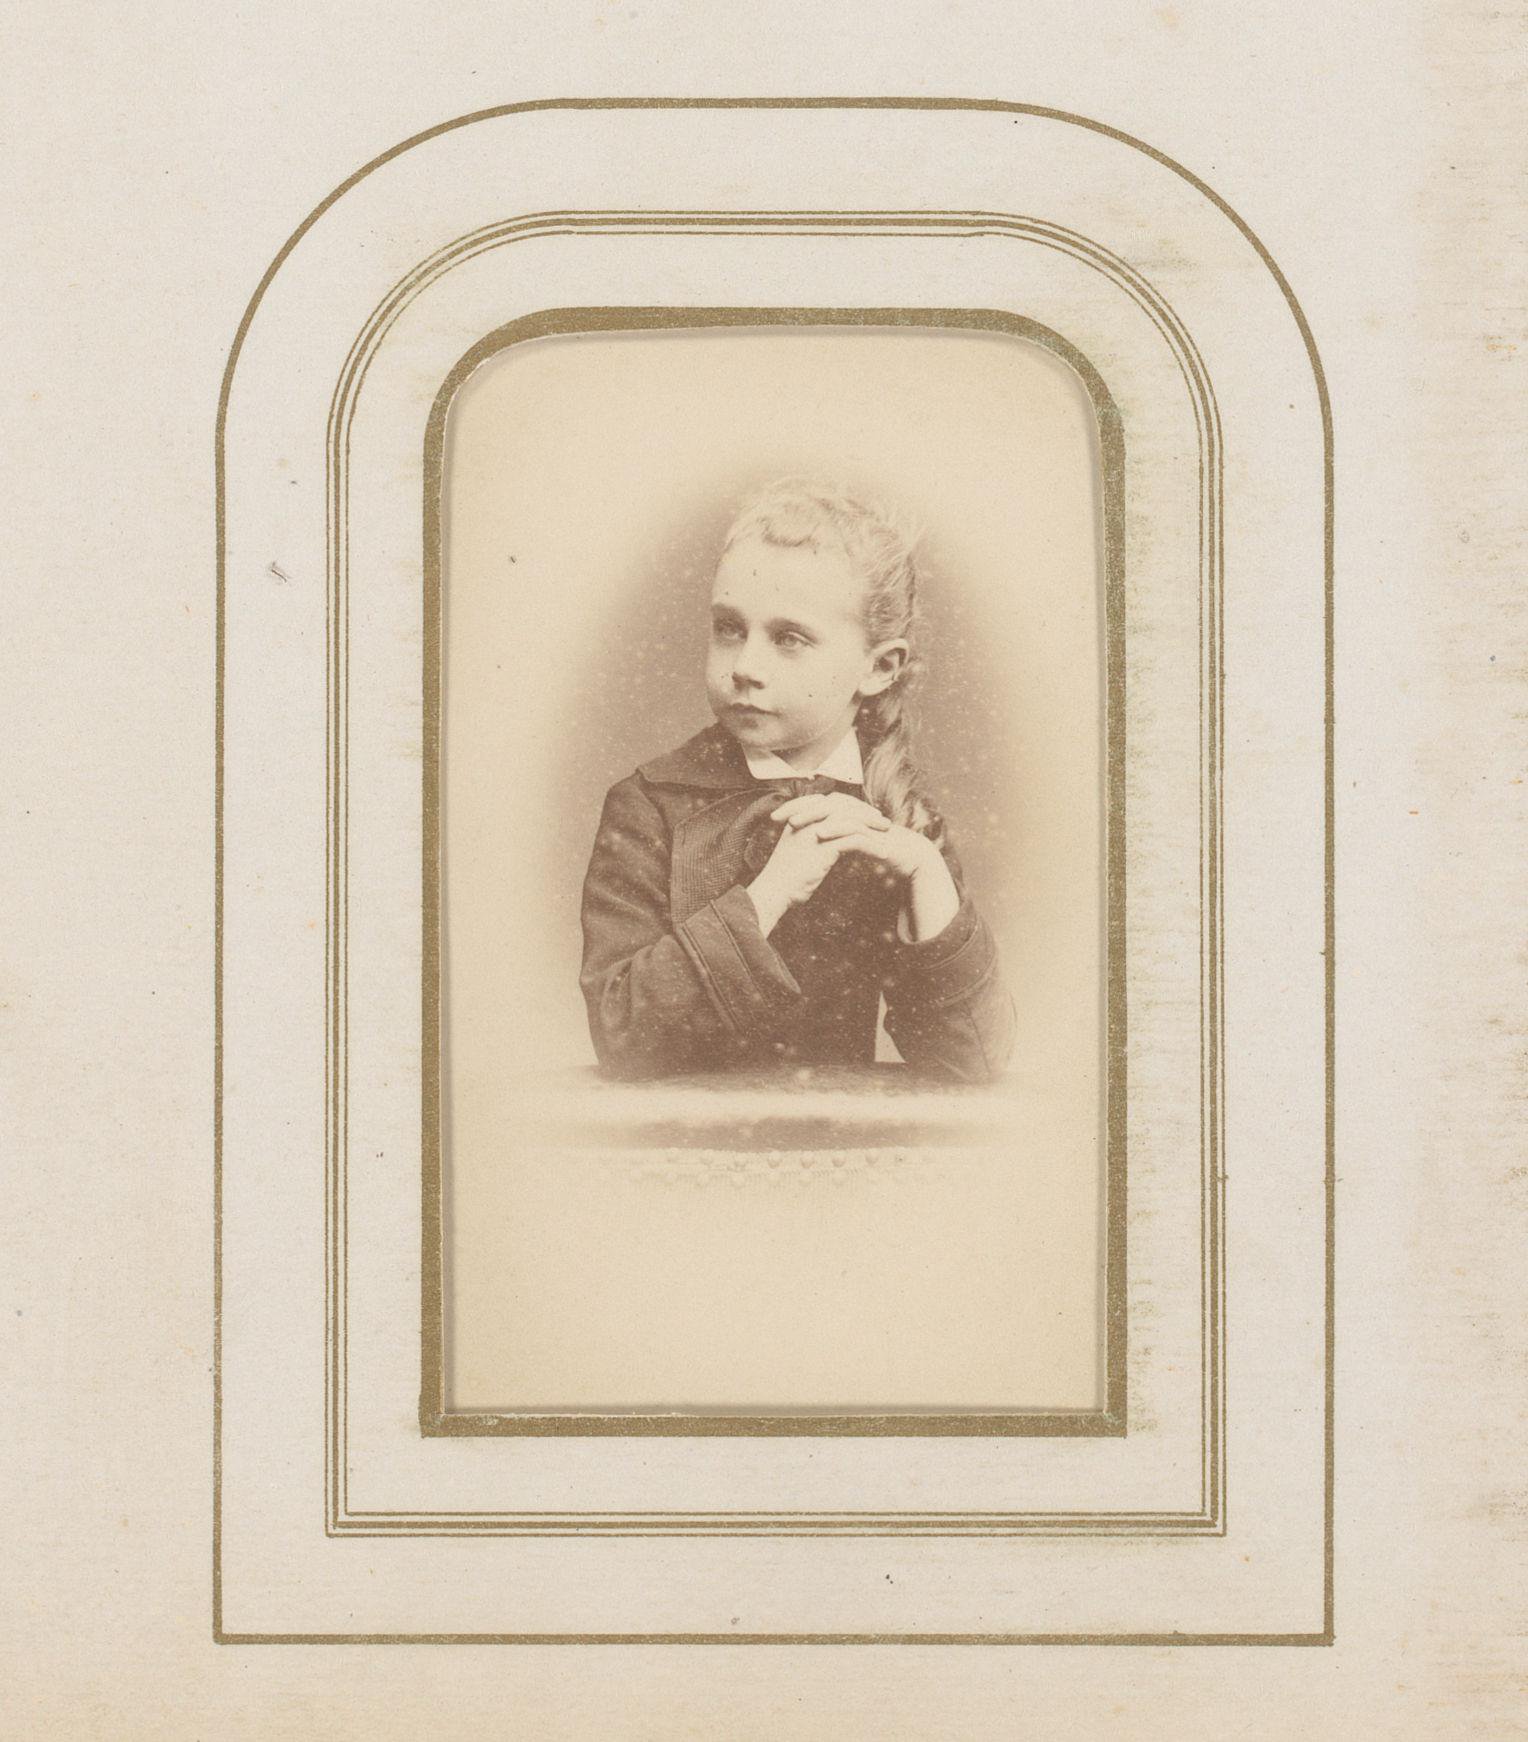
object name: album leaf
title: Portret van een man, zittend aan een tafel met boek en hoge hoed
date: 1861-1862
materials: cardboard, photographic support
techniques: albumen print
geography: paris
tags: sitting figure, historical persons, head-gear: top hat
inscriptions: annotation: ‘à mon bon camarade/ le capitaine Lemoine/ [Gand], le 6 mars 1862 [...]’, inscription: ‘Disderi & Cie/ Photographes de S.M. l'empereur/ 8, Boulevart des Italiens/ Paris’